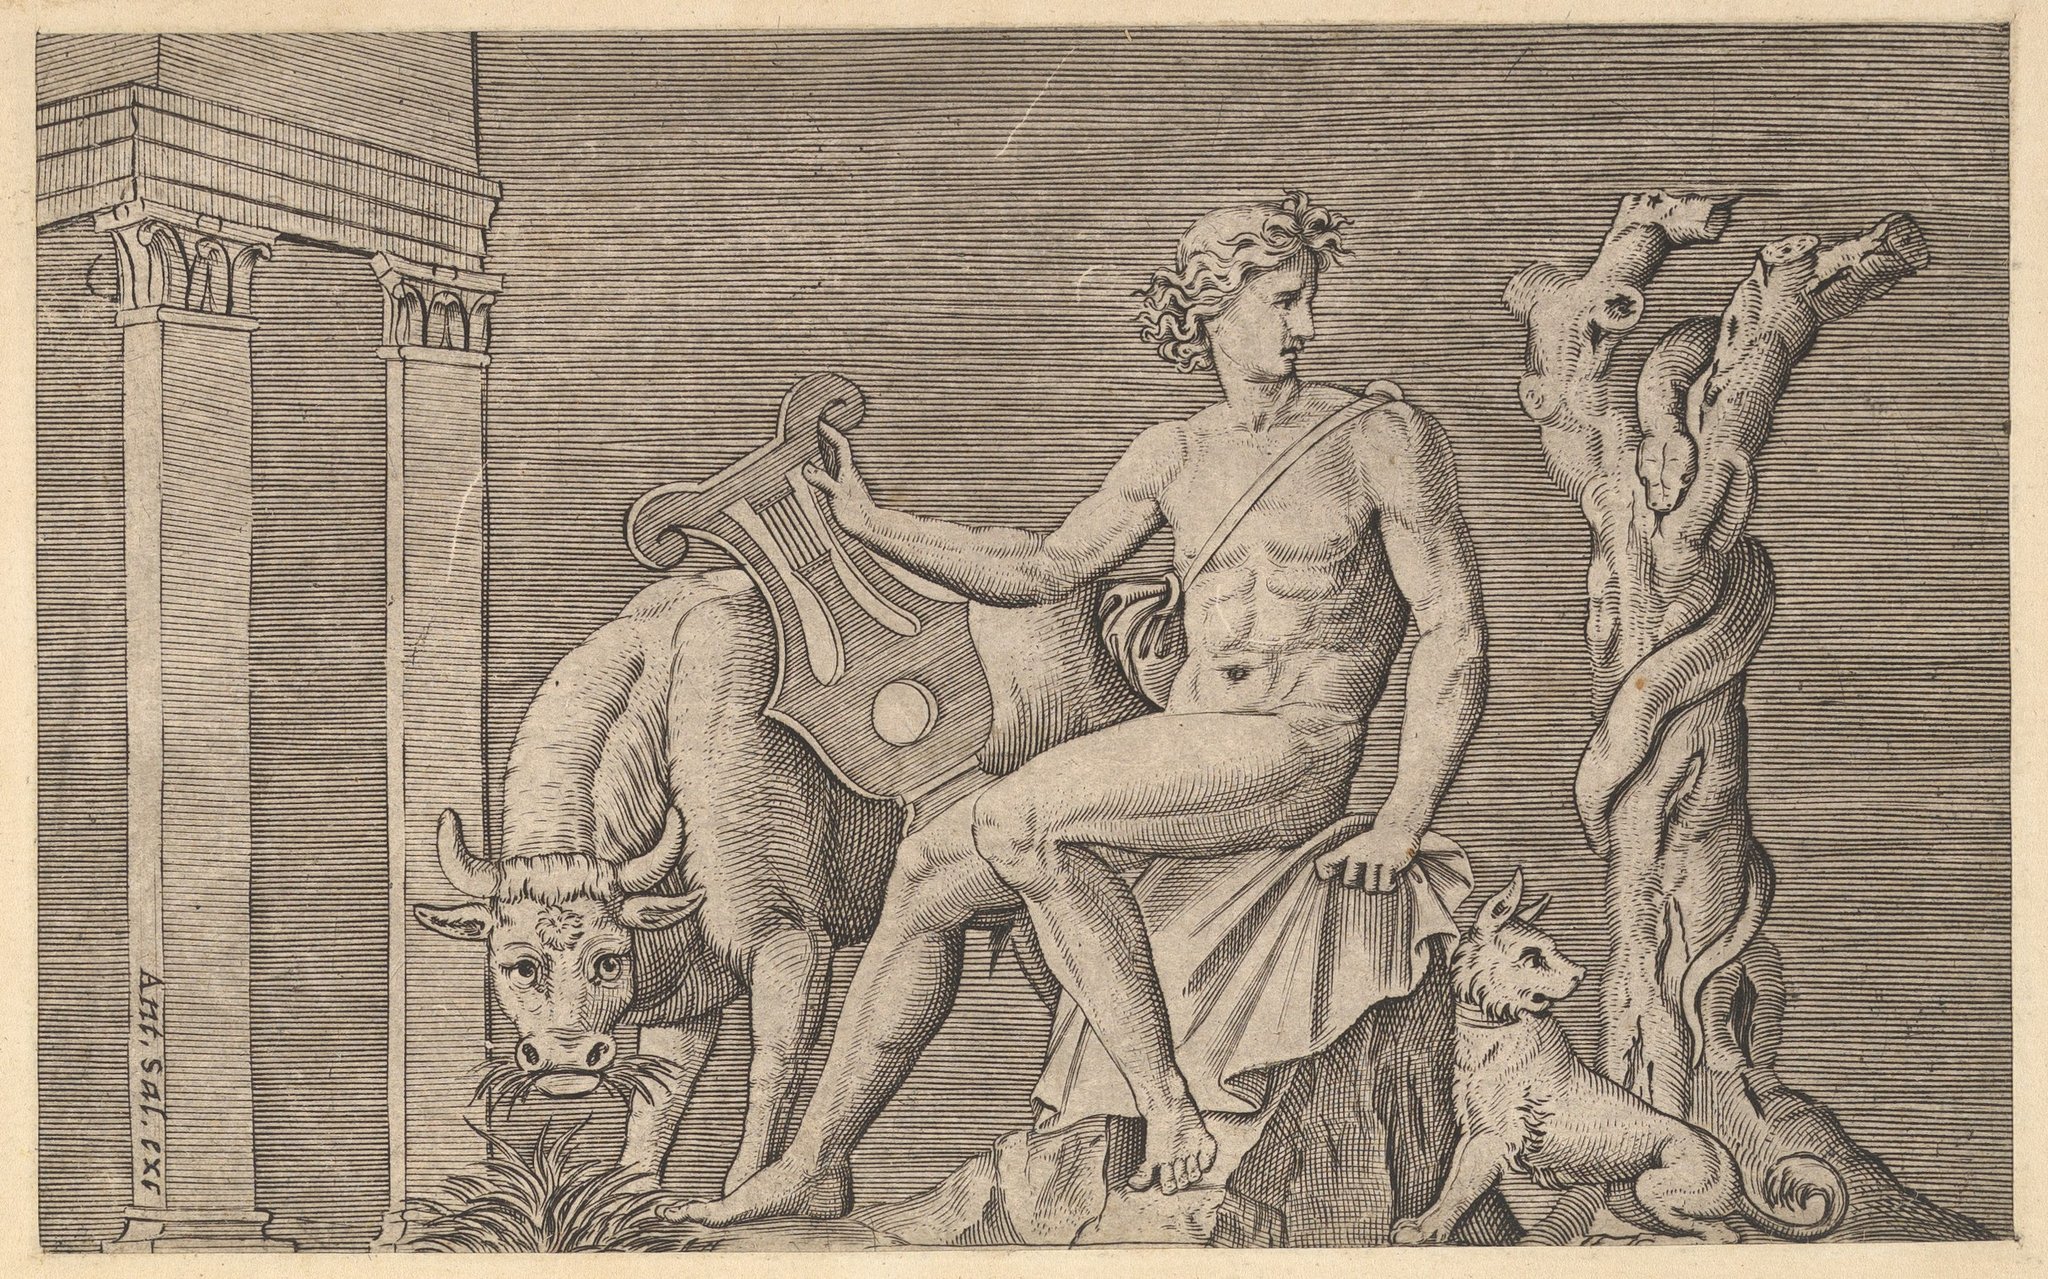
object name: print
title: Apollo Tending the Flocks of Admetus, from "Speculum Romanae Magnificentiae"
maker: marco dente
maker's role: artist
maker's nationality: italian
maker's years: 1515-1527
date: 1501-1600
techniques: engraving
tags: musical instruments,columns,apollo,bulls,dogs,snakes